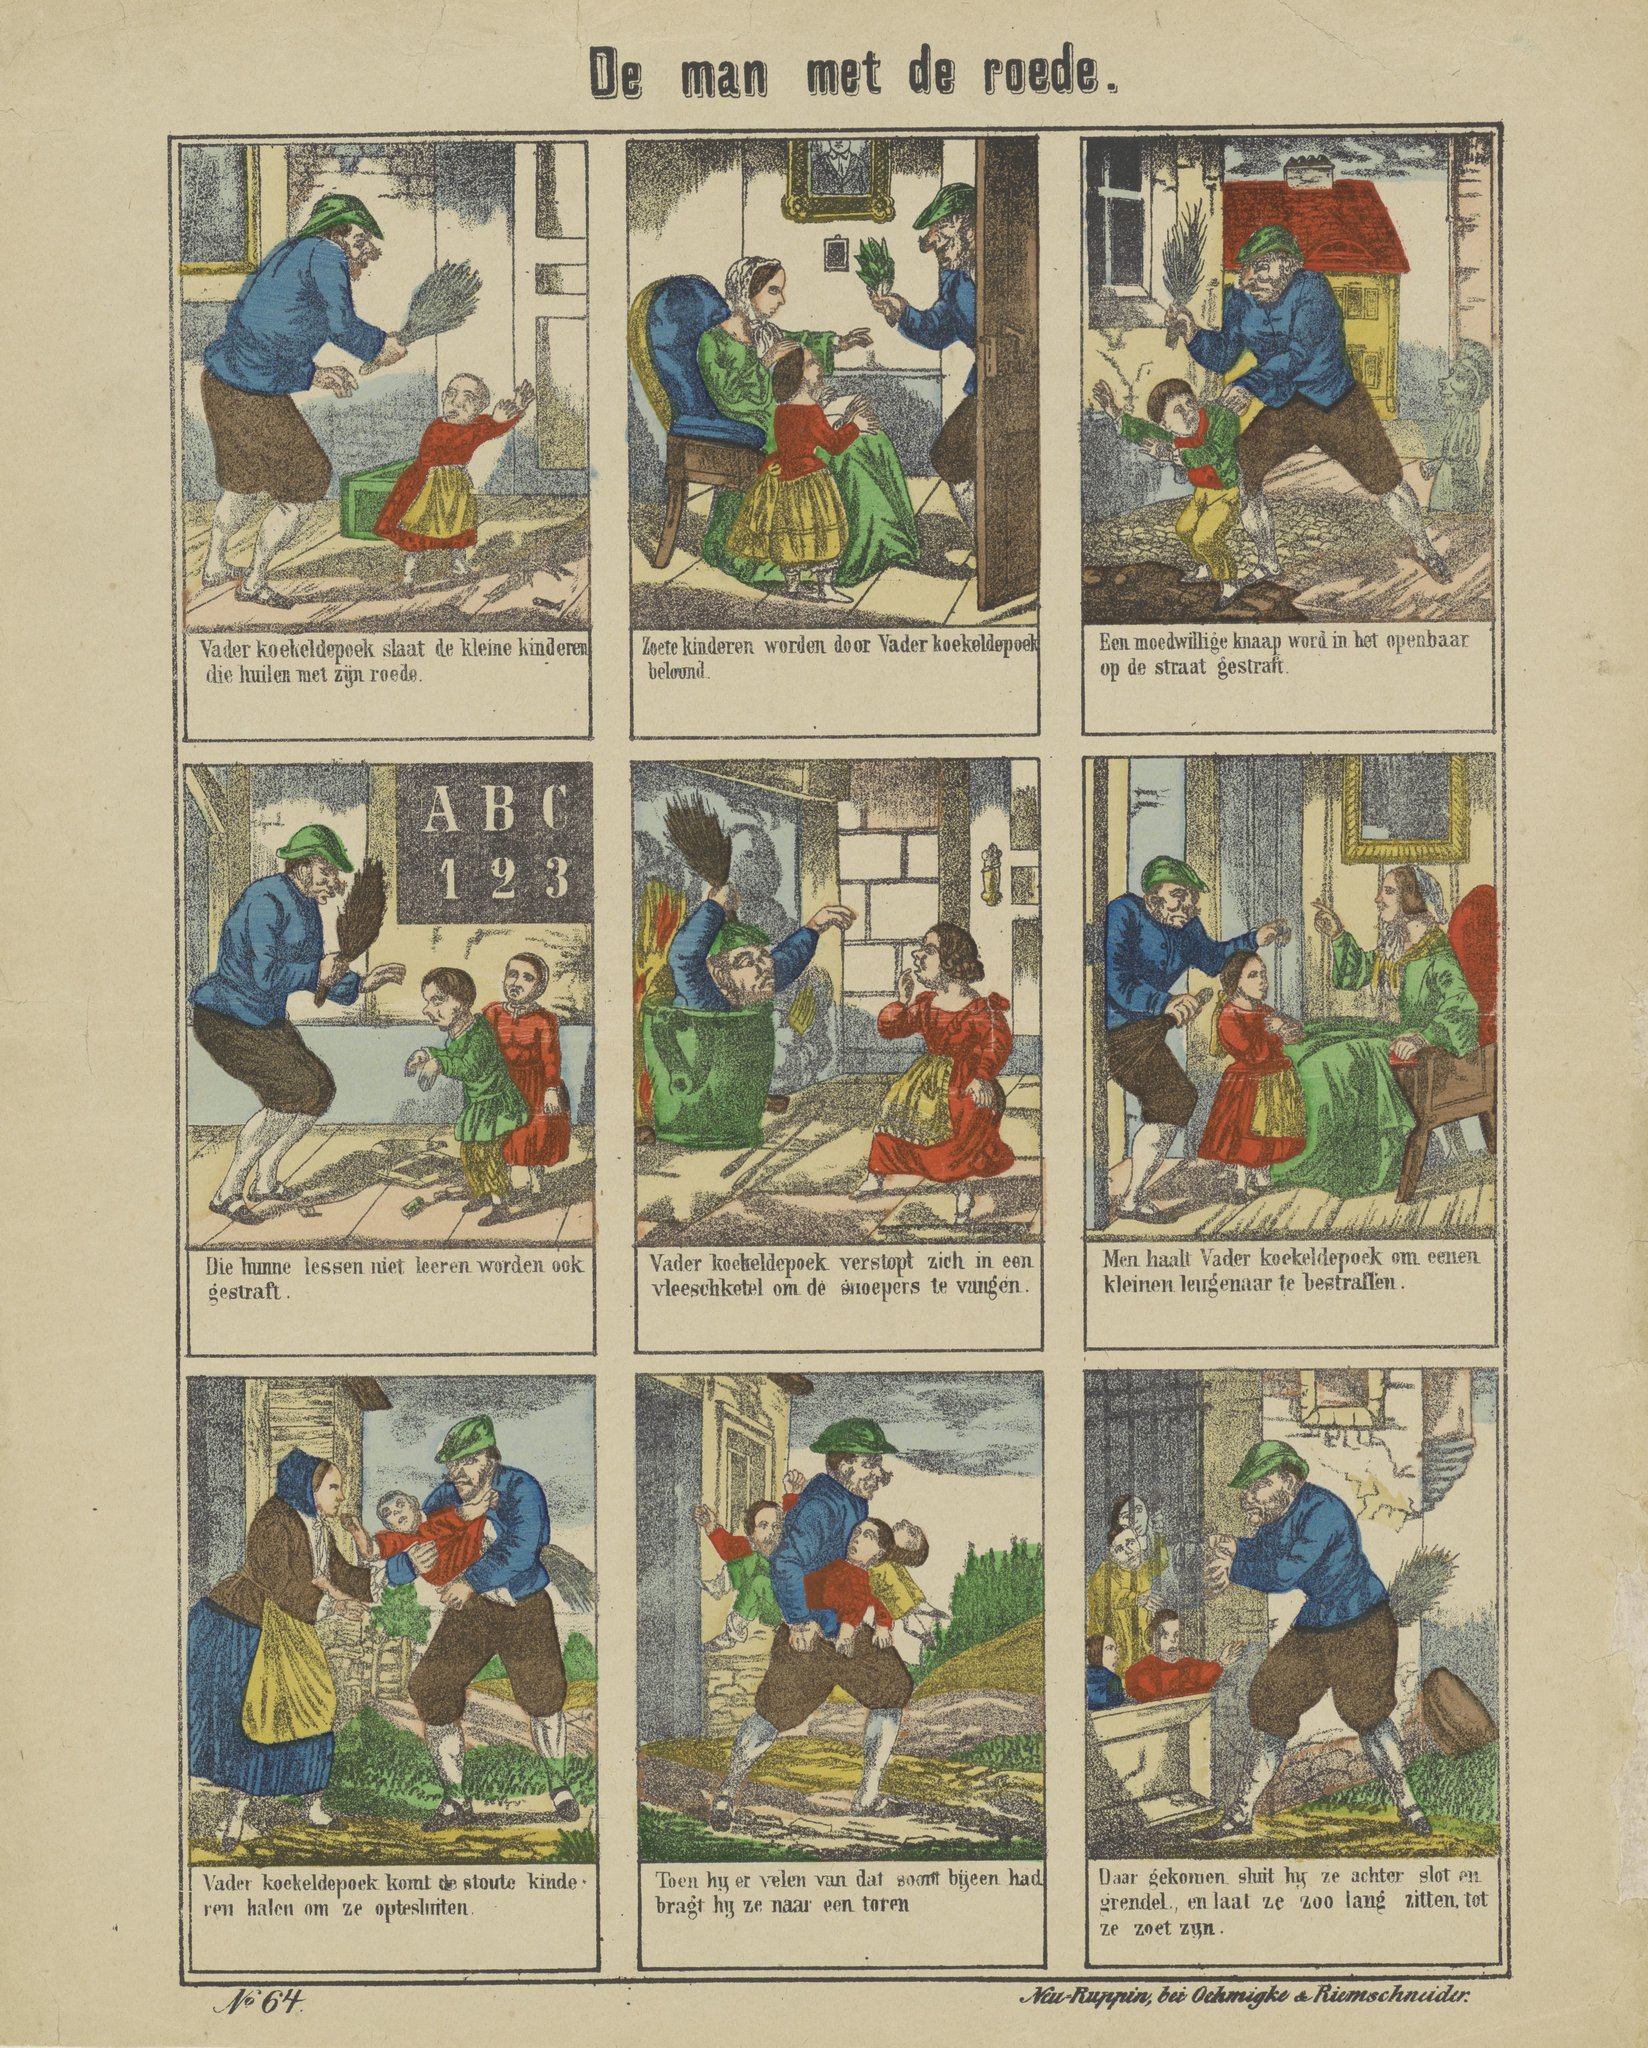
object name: popular print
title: De man met de roede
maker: Anonymous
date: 1828-1937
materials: paper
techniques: hand coloring, letterpress printing, lithograph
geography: neuruppin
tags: tales and fairy tales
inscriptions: collector's mark: Lugt 2760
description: Blad met 9 voorstellingen uit het verhaal van vader Koekeldepoek met de roe. Onder elke afbeelding een onderschrift. Genummerd linksonder: No. 64.